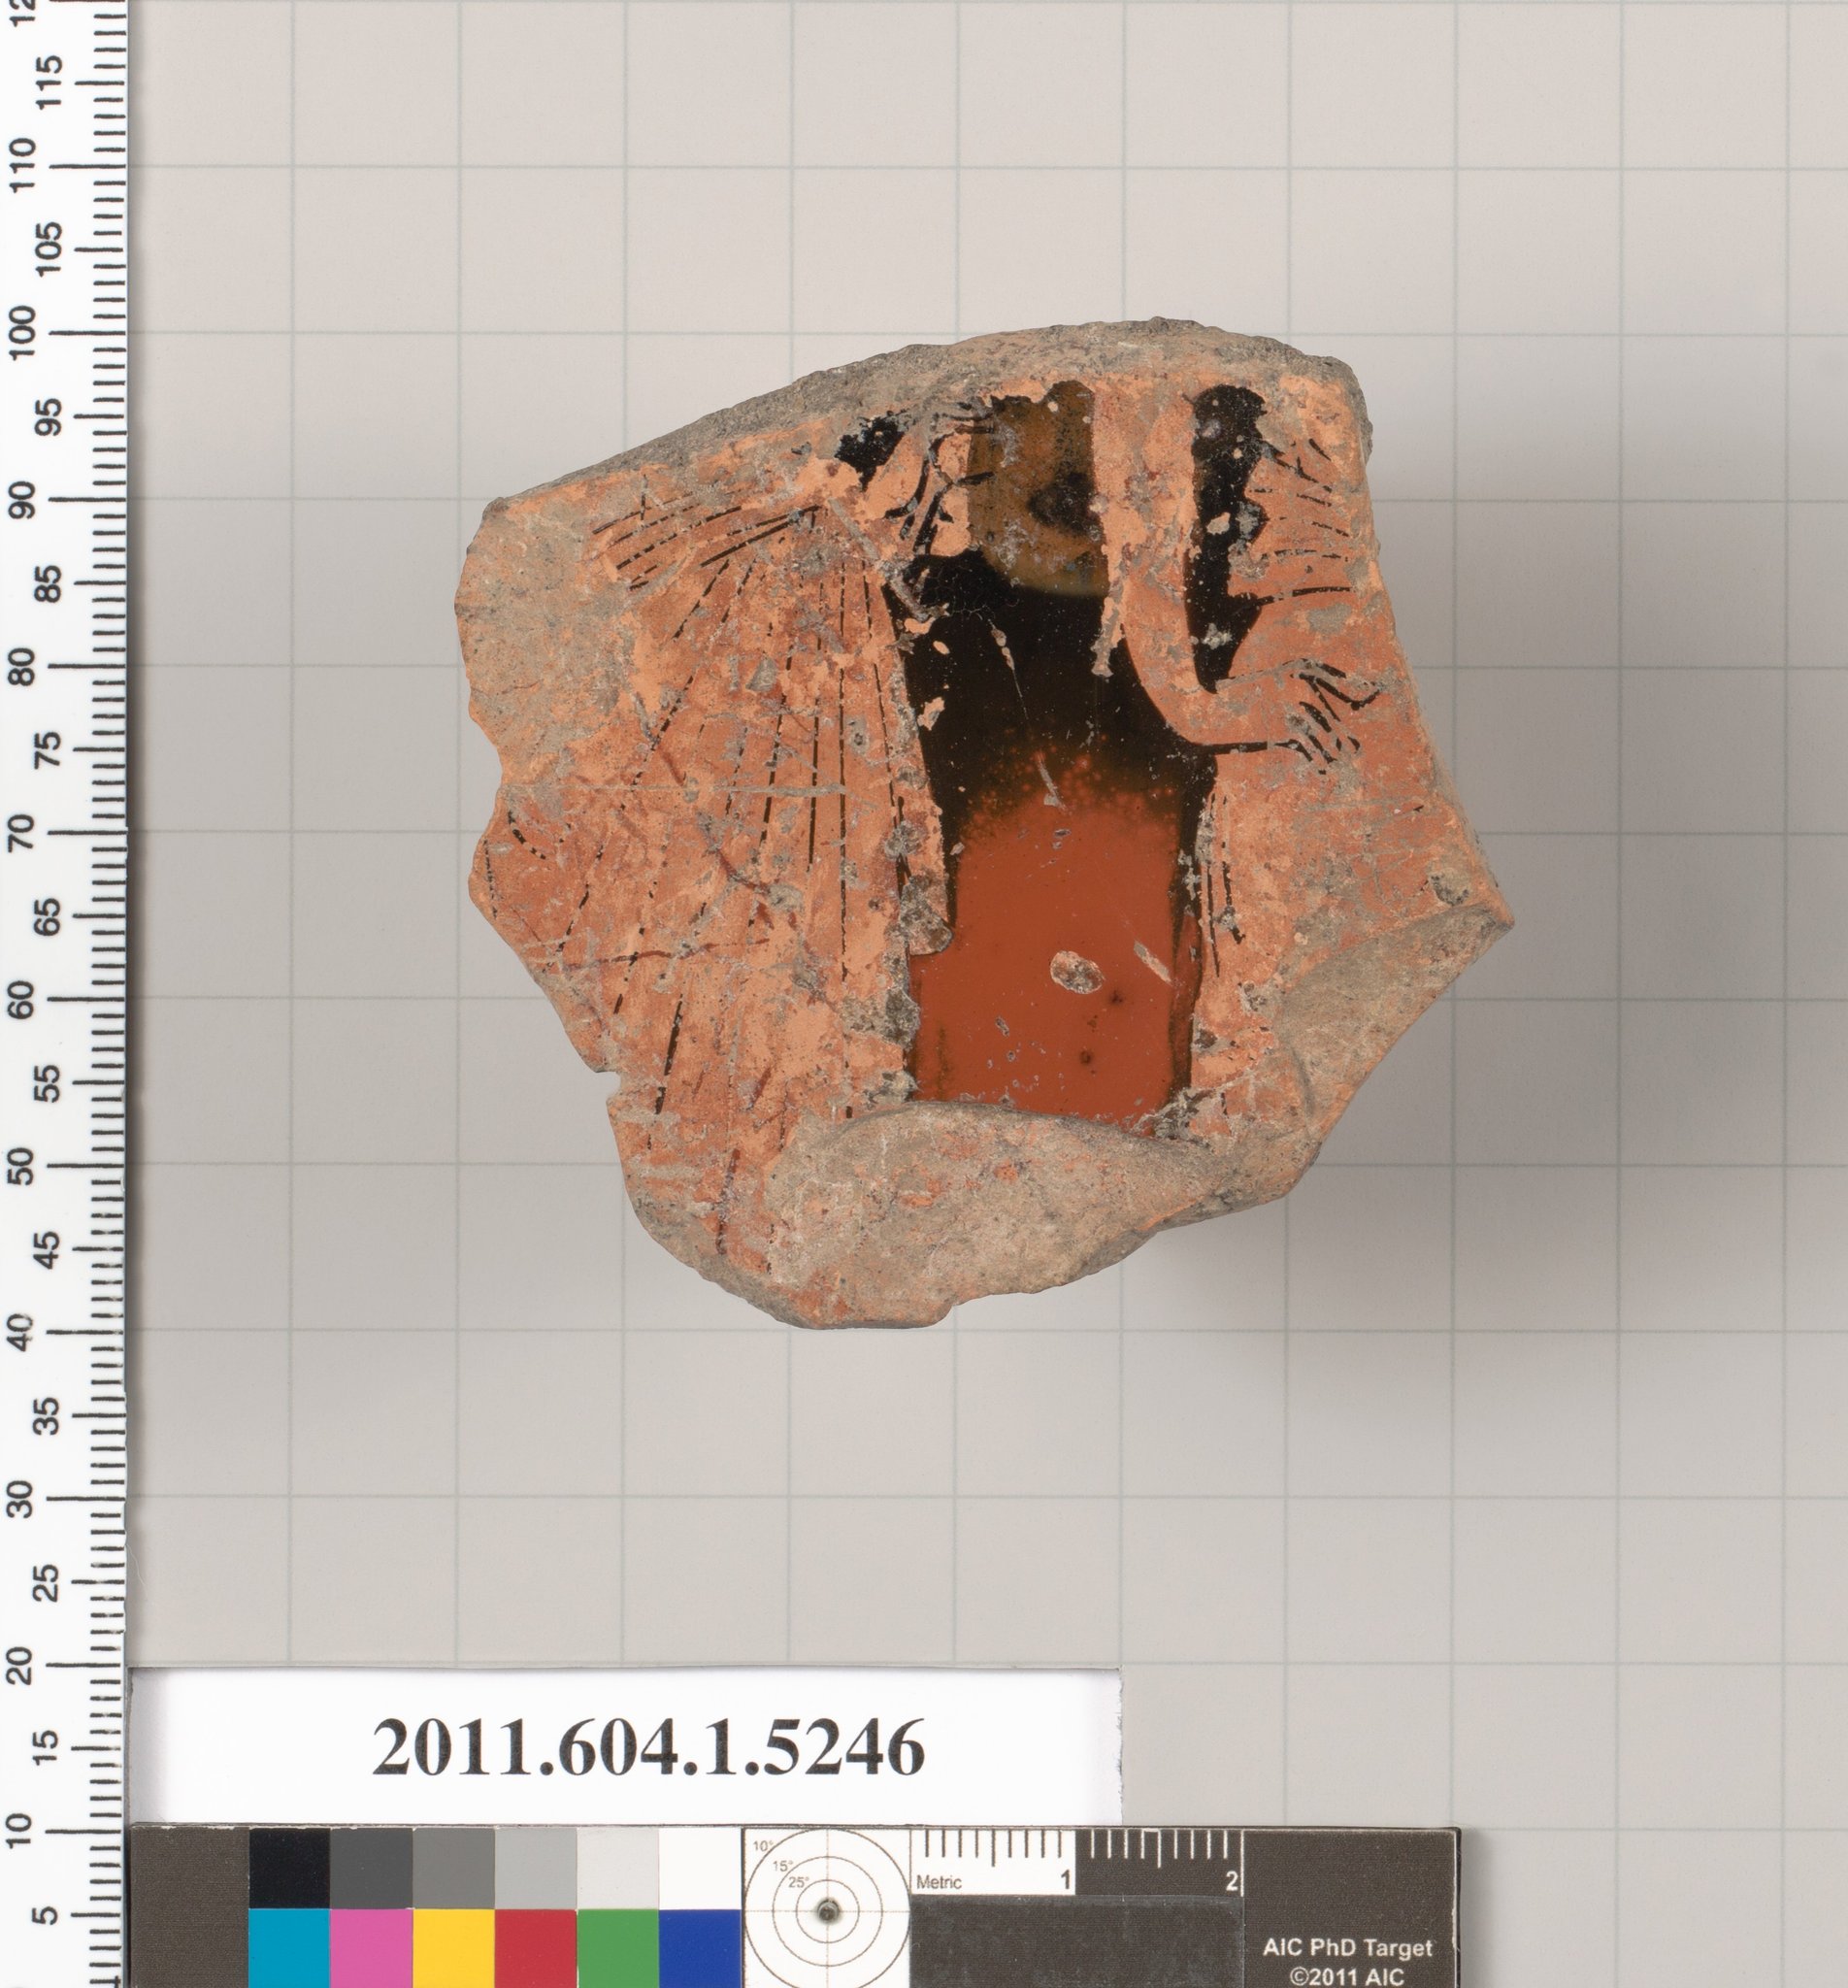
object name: kylix fragment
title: Terracotta fragment of a kylix (drinking cup)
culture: greek, attic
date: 475-451 BCE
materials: terracotta